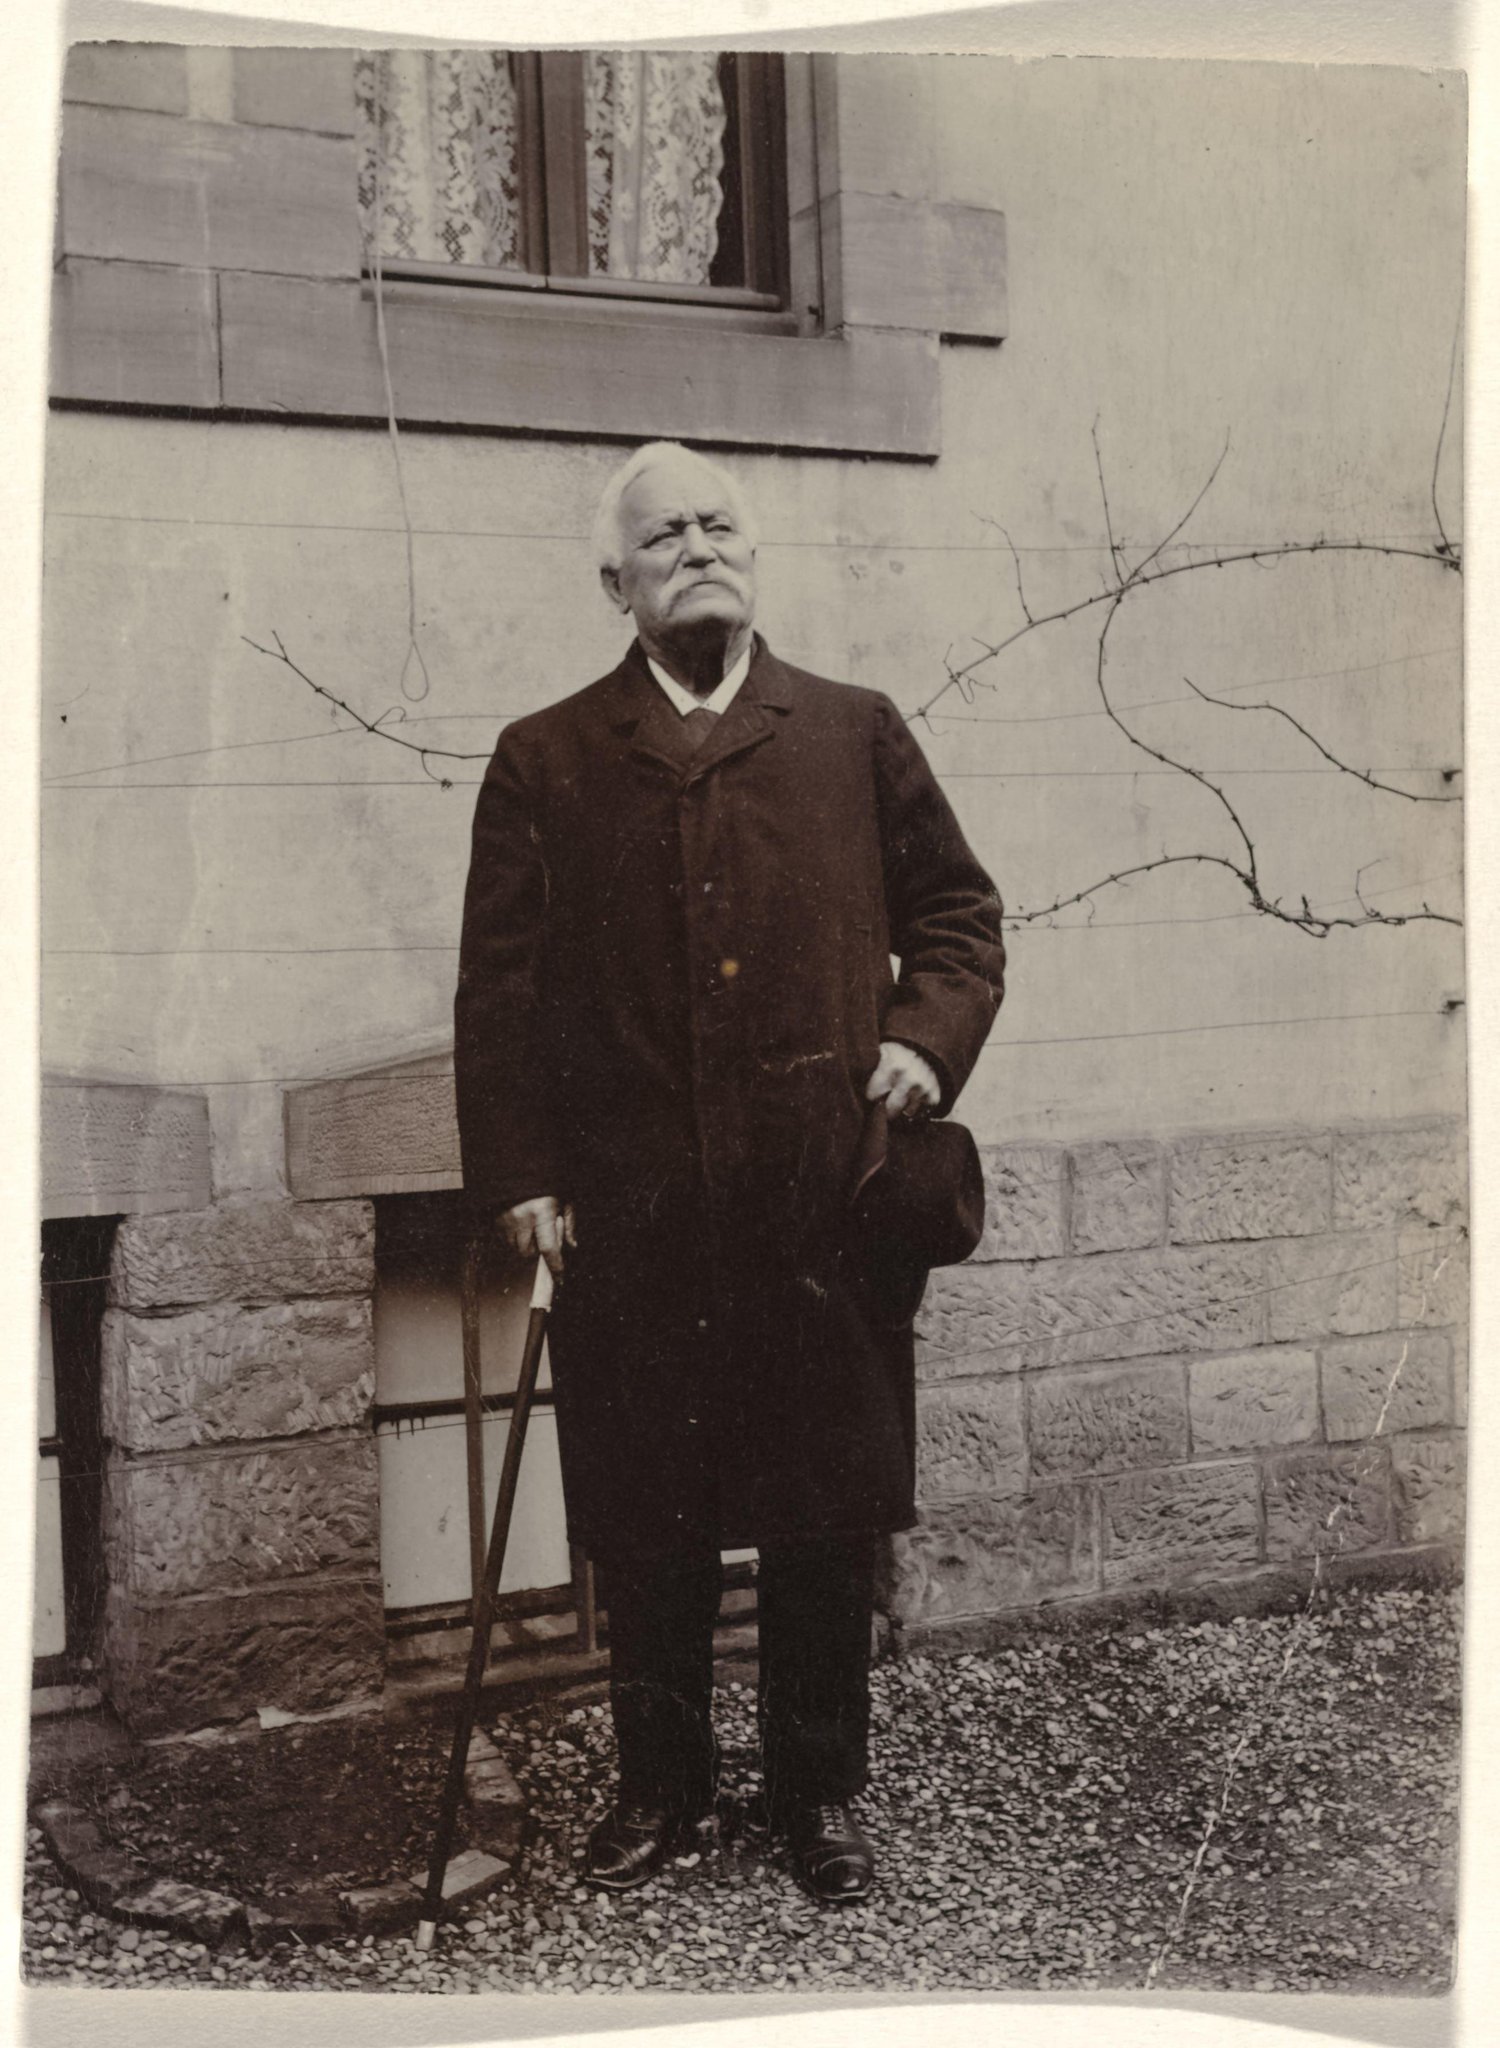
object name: photograph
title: Oudere man met snor, en loopstok en hoed in zijn handen, staand voor een gebouw met begroeiing en met twee ramen op beenhoogte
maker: Anonymous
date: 1890-1940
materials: photographic support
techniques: gelatin silver print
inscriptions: name: ‘Herr Wachenheimer’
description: Oudere man met snor, en loopstok en hoed in zijn handen, staand voor een gebouw met begroeiing en met twee ramen op beenhoogte.